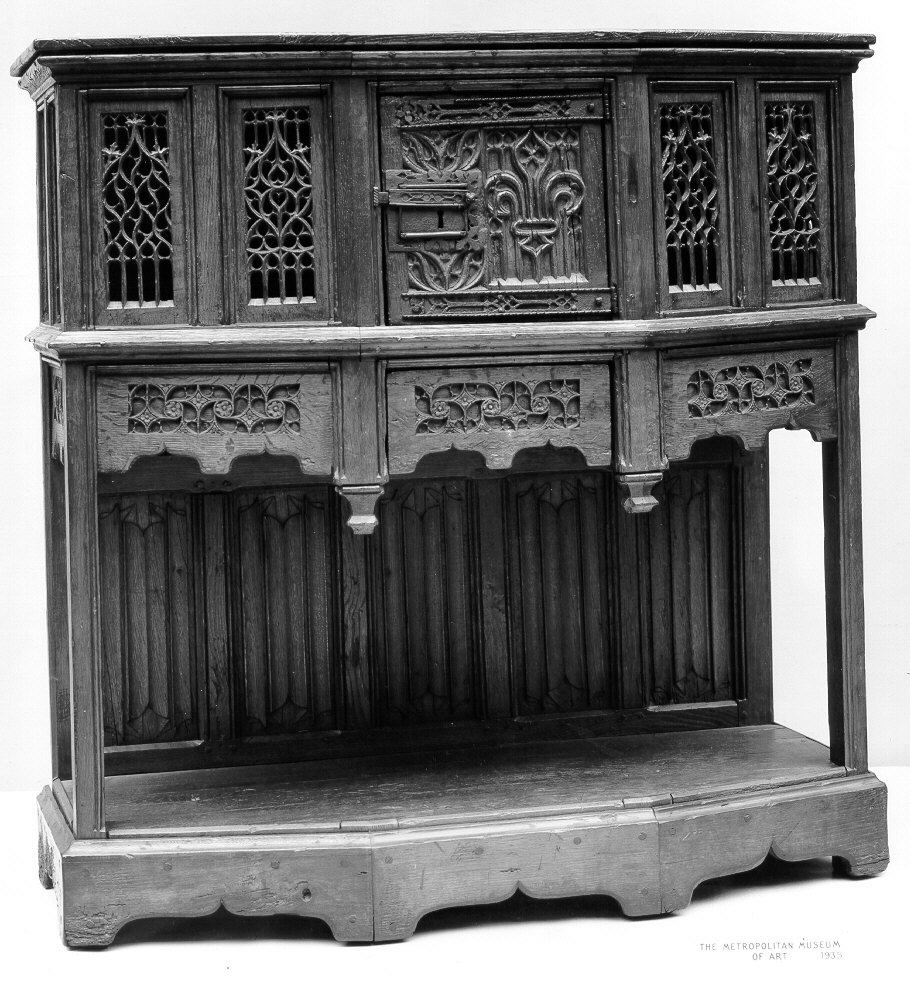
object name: credence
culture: french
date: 1401-1600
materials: iron, wood